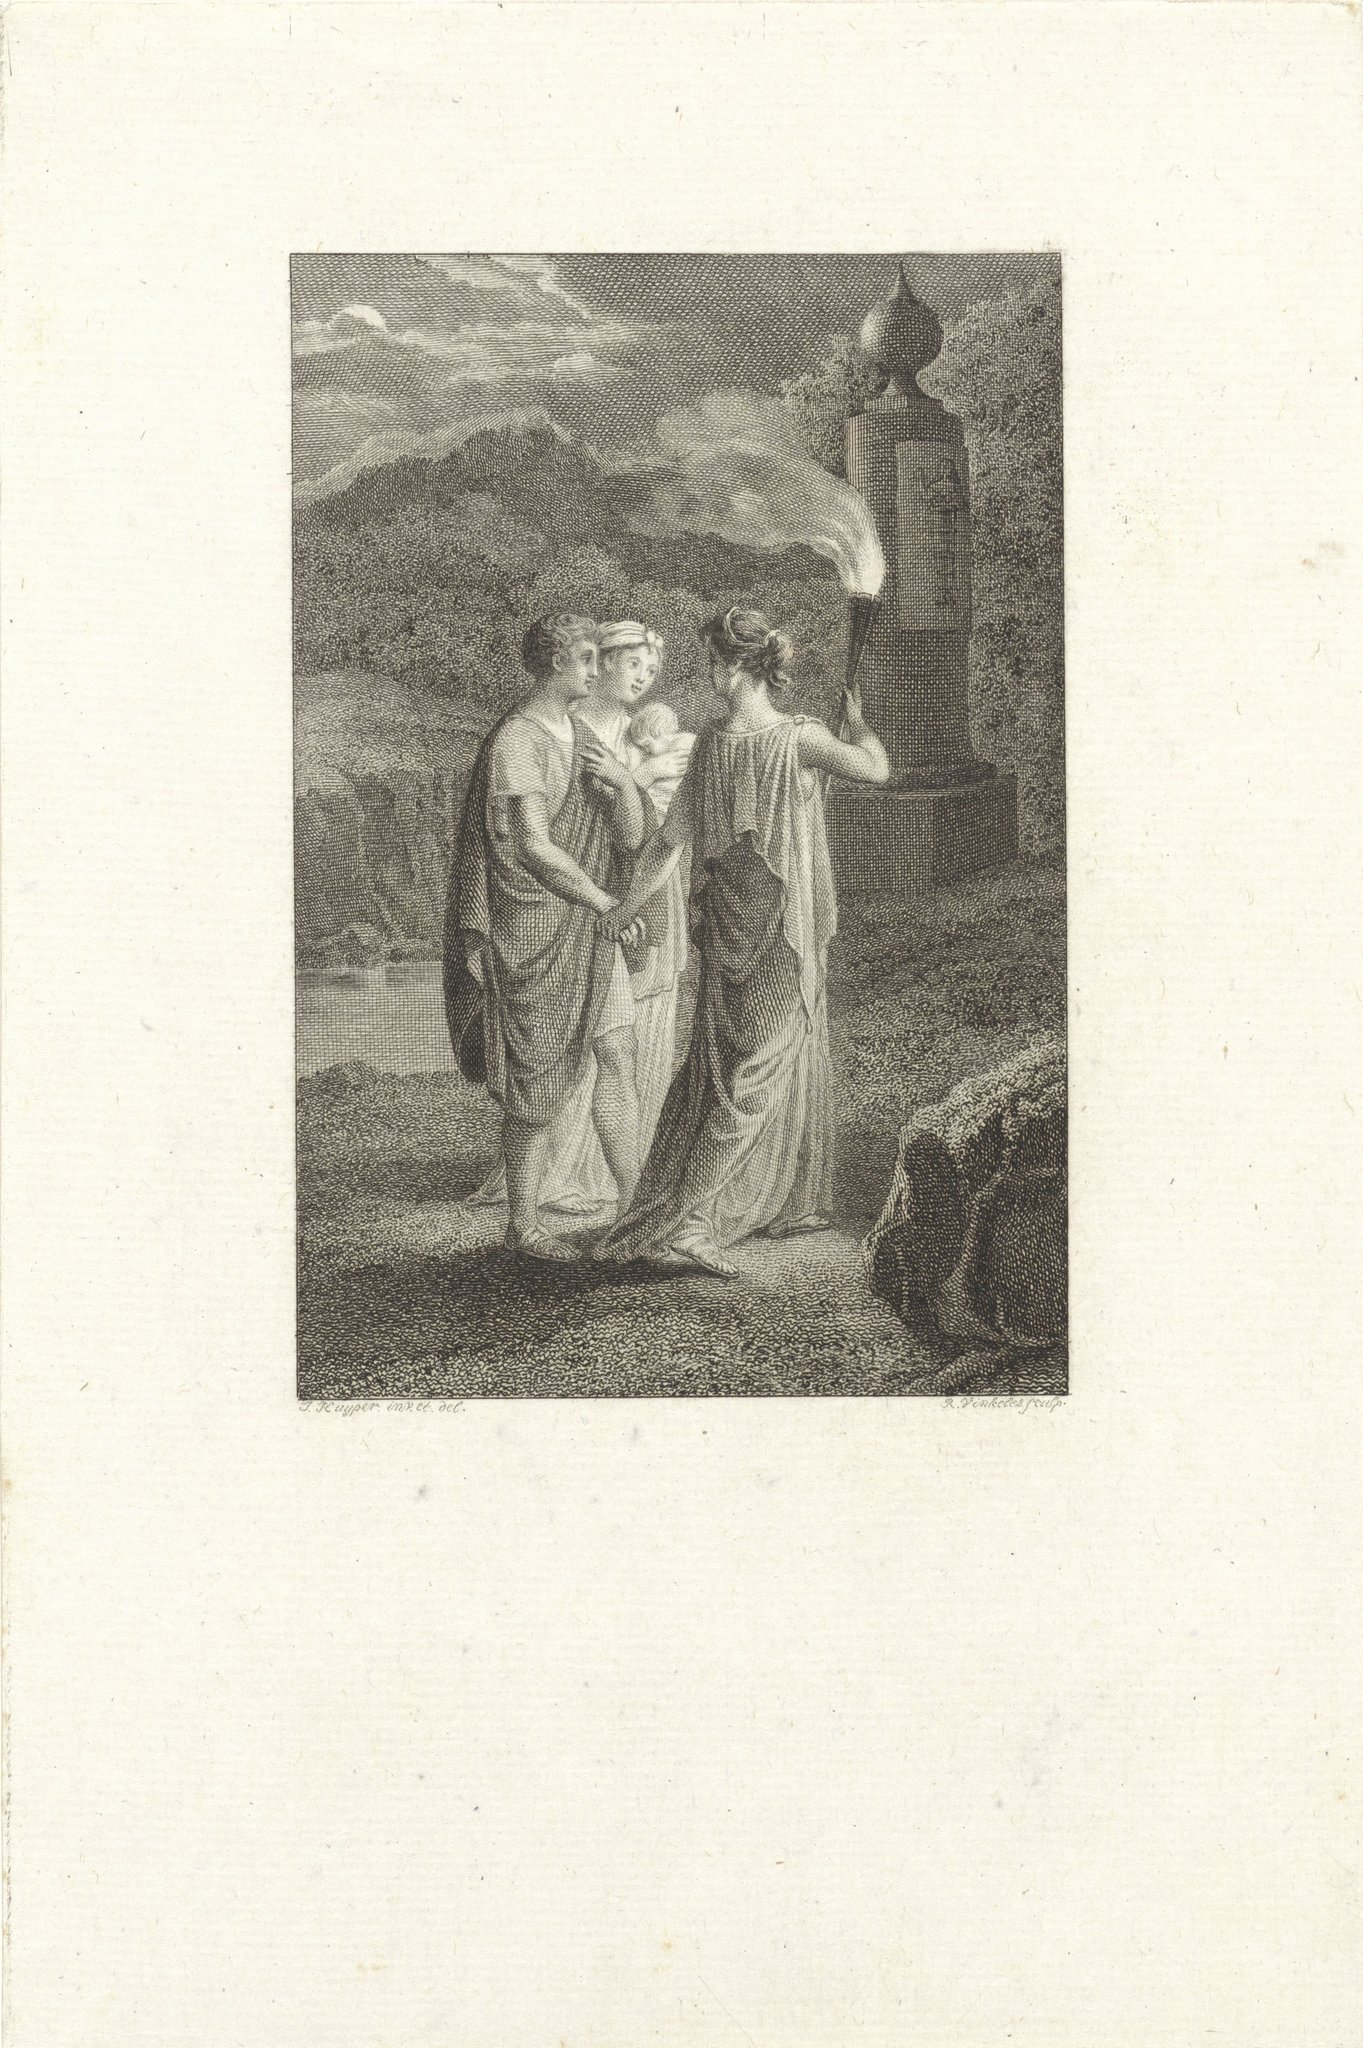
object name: print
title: Nachtgezicht met drie figuren met een baby in een landschap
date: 1807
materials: paper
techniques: engraving, etching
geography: amsterdam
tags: torch, night ~ landscape (sometimes titled 'nox'), infant, baby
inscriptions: collector's mark: Lugt 2228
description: Proefdruk van illustratie voor: Bilderdijk, Willem. De Mensch: Popes Essay on men. Amsterdam: Johannes Allart, 1807, p. 35-36.